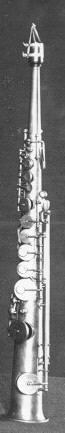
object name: soprano saxophone in b flat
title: Soprano saxophone in B-Flat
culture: french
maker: adolphe (antoine joseph) sax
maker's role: maker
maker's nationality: belgian, active france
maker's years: 1814-1894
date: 1882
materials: brass, wood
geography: france